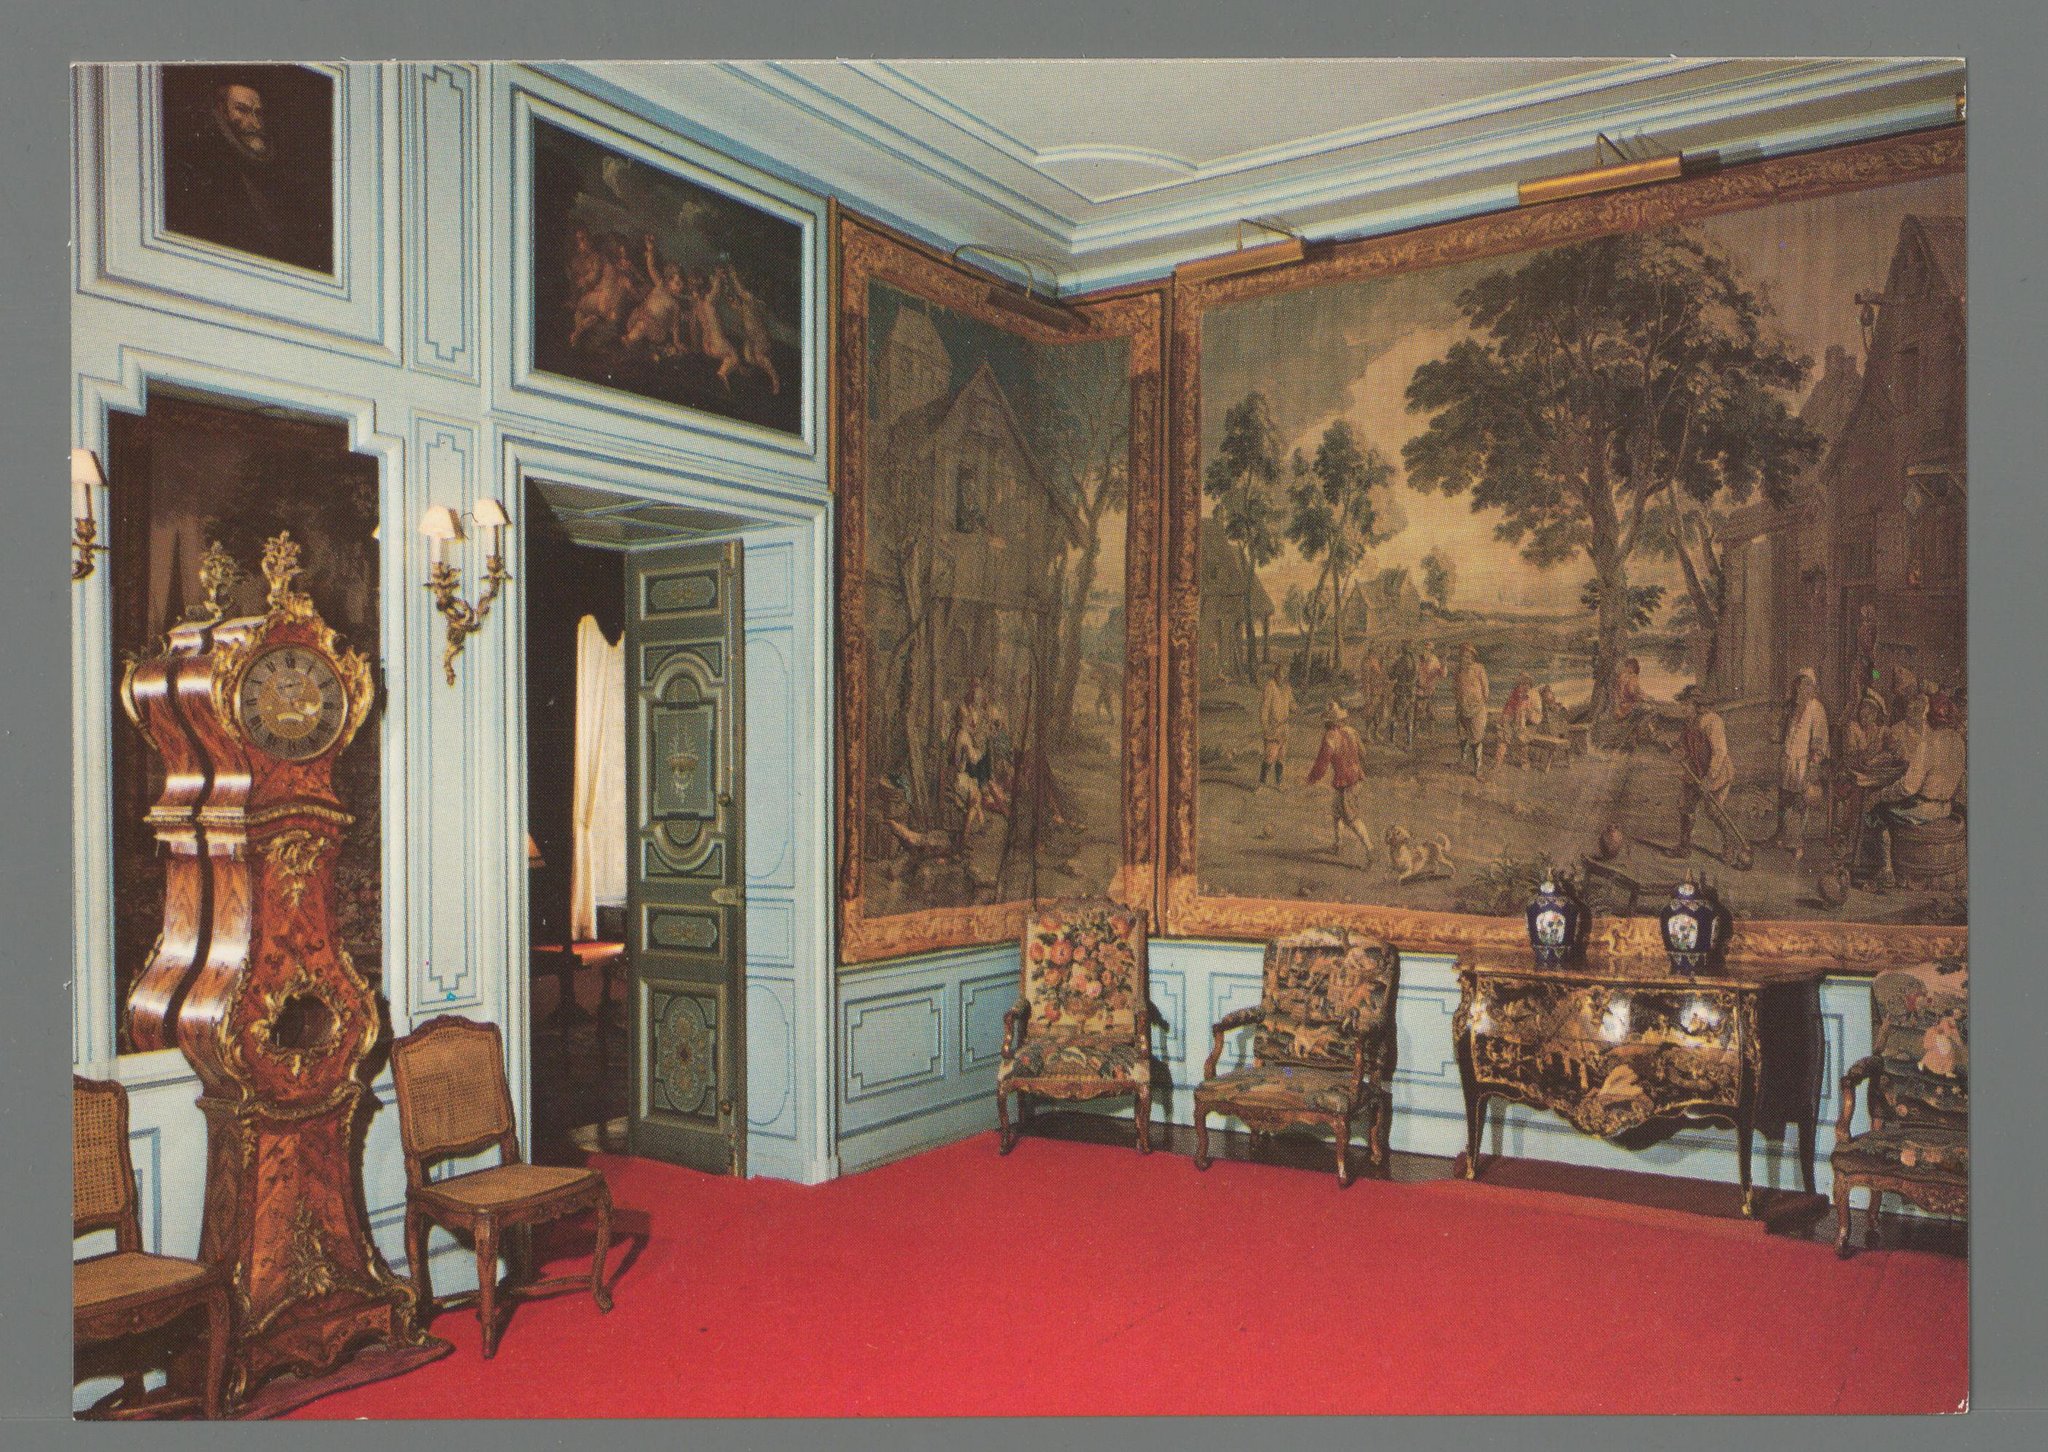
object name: ansichtkaart, prentbriefkaart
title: Cheverny (L.-et-Cher). Le château. Le petit salon. Tapisserie des Flandres (...)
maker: Anonymous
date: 1958-1982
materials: cardboard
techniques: offset printed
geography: mâcon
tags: drawing-room, 'salon', castle, interior ~ representation of a building